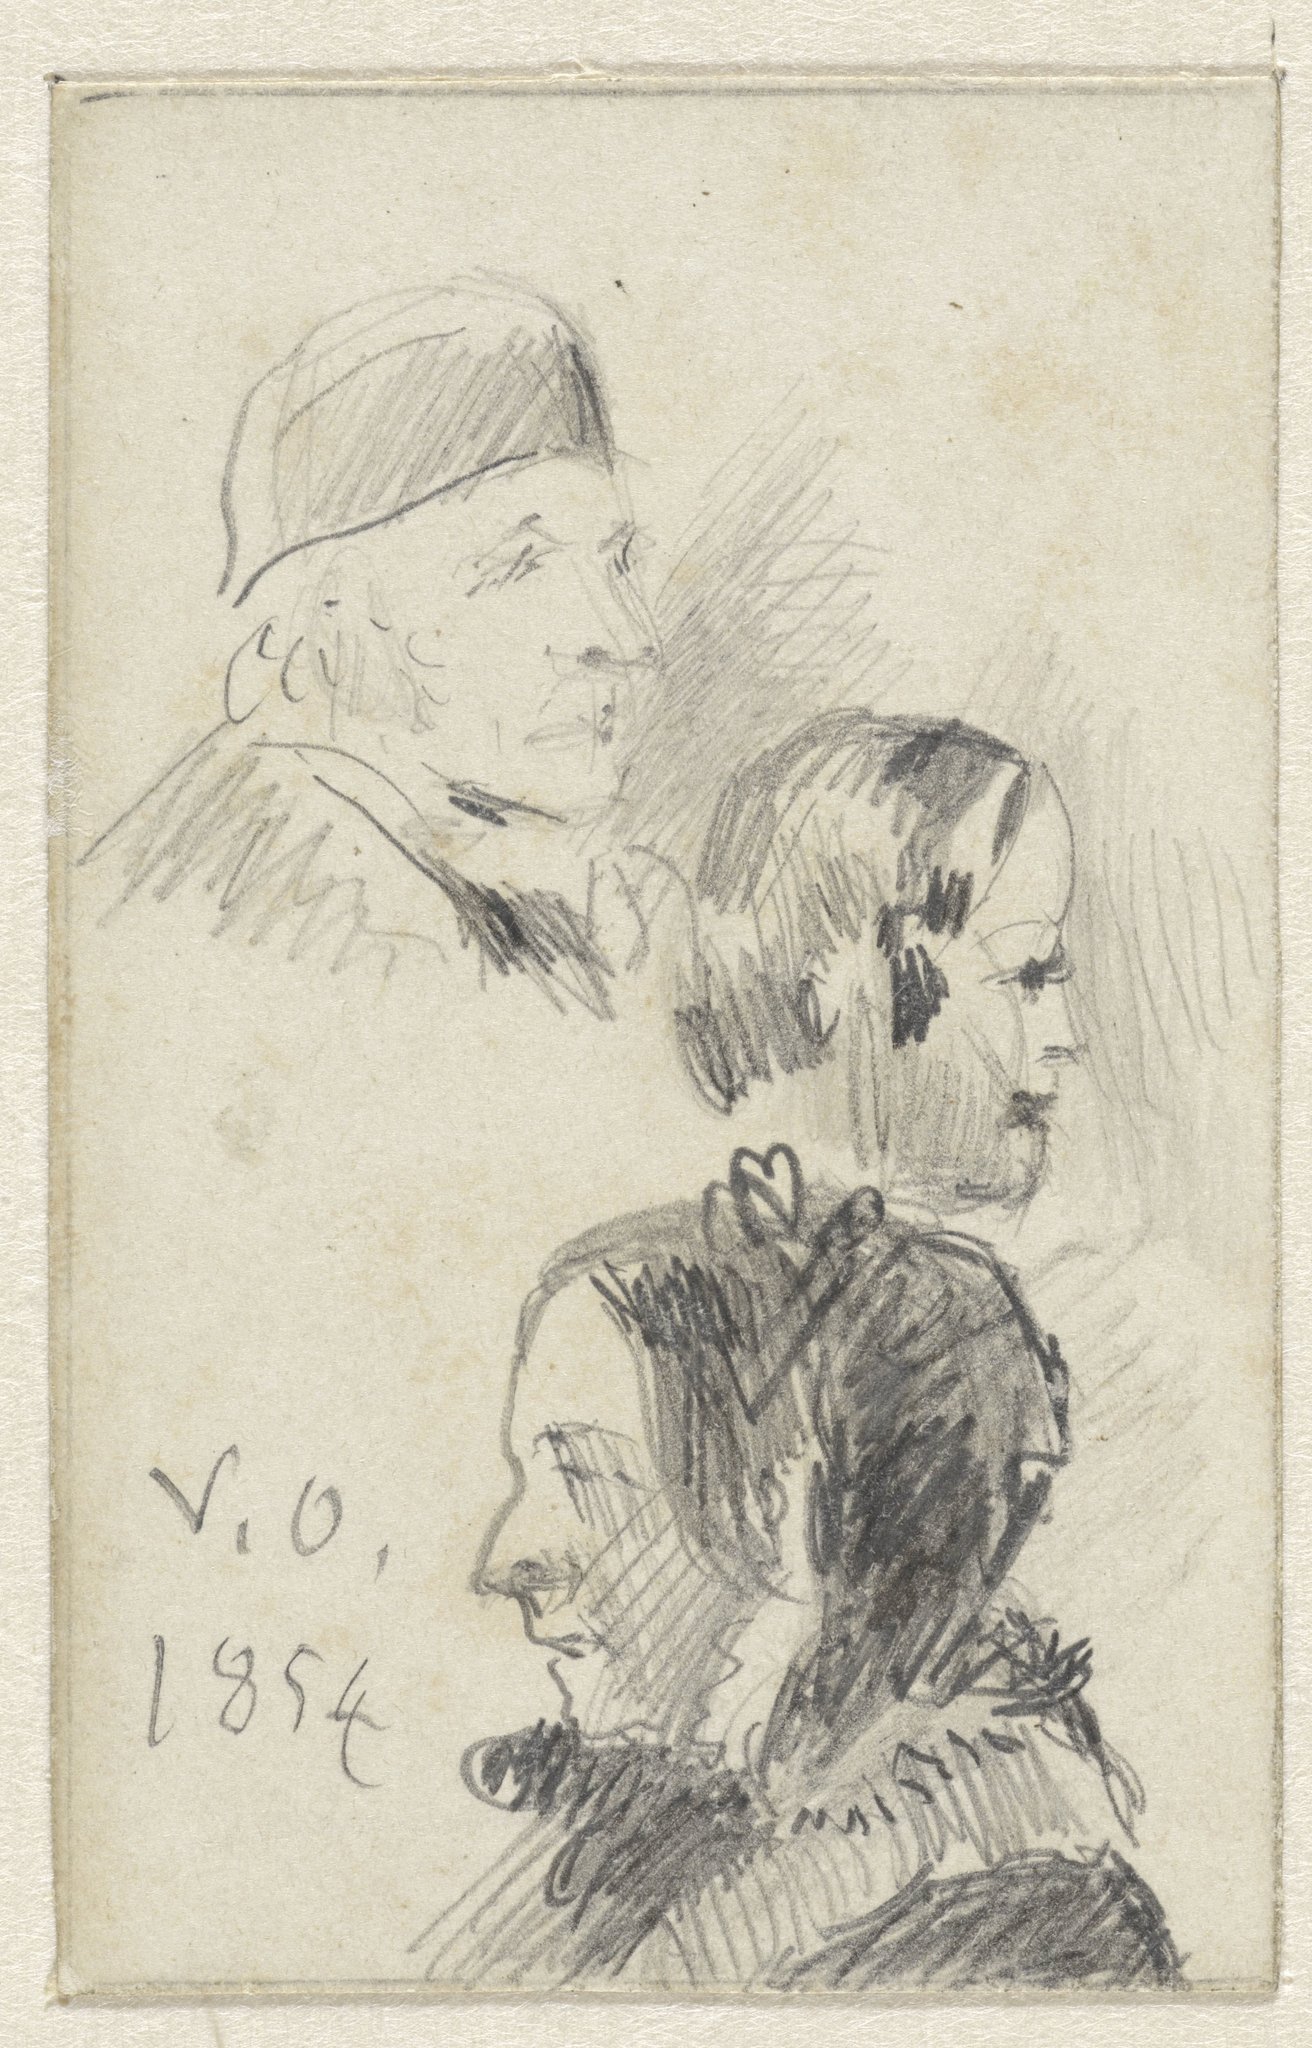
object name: drawing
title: Studies van drie hoofden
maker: georgius jacobus johannes van os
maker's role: draughtsman, painter, print maker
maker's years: 1782-1861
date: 1854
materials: paper, pencil